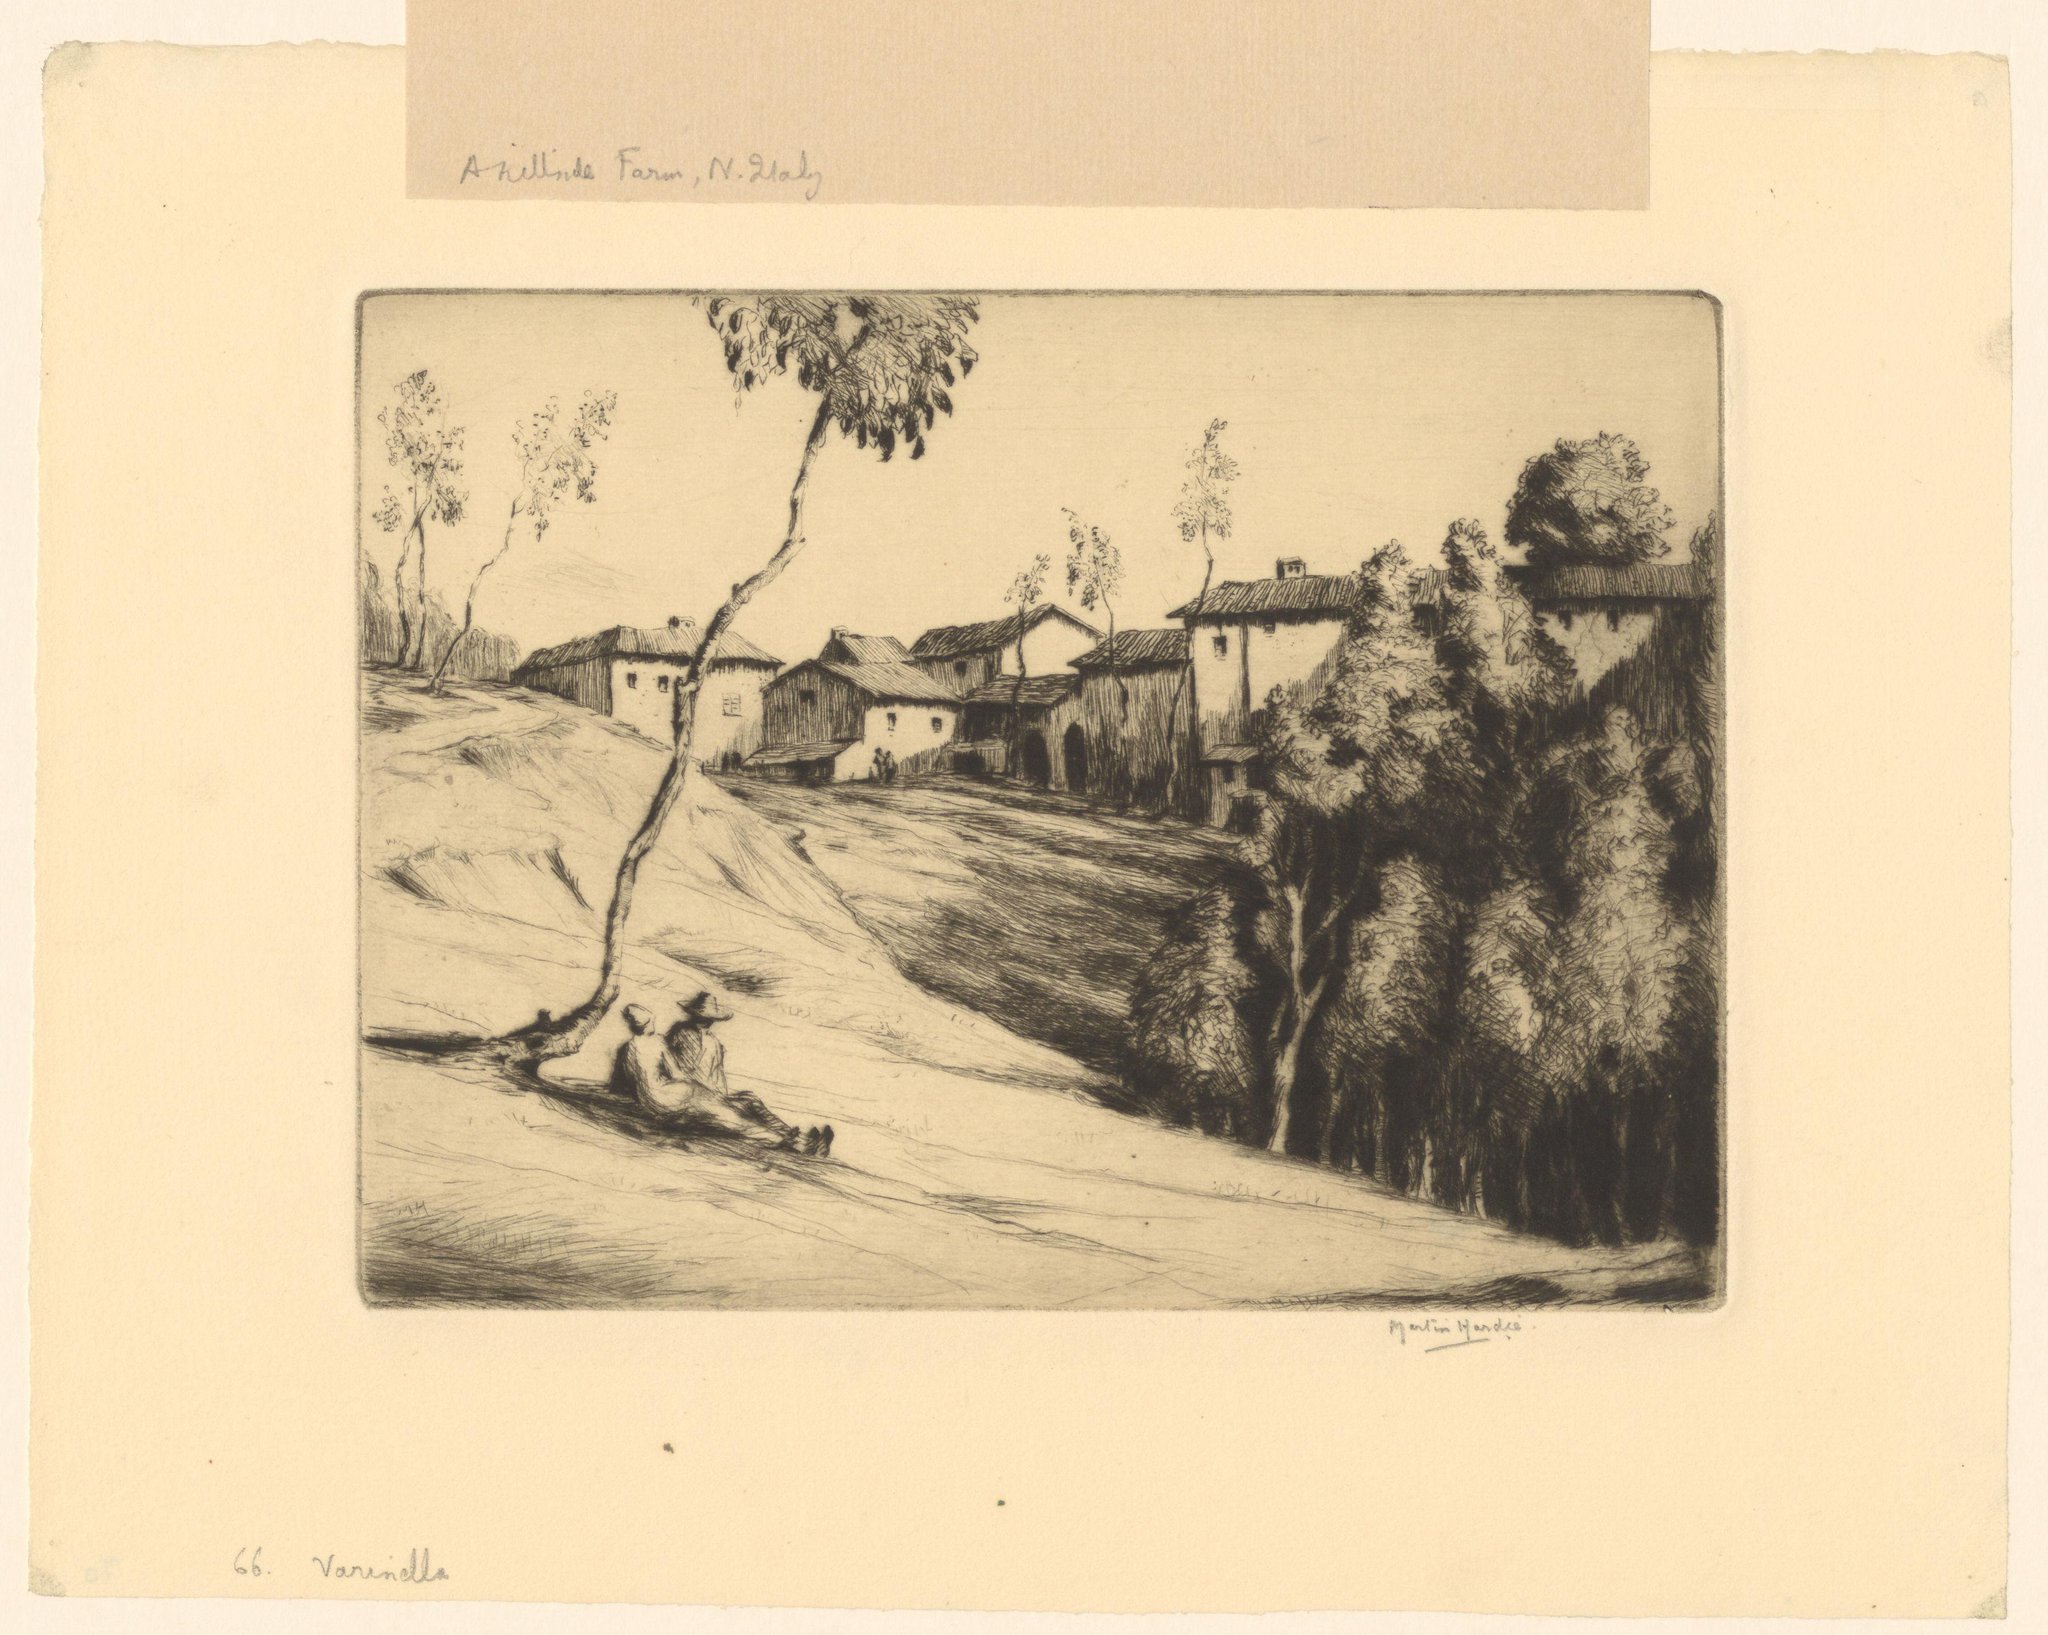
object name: print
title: Gezicht op het dorp Varinella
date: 1918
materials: paper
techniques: drypoint, etching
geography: arquata scrivia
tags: village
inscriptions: collector's mark: Lugt 2760, collector's mark: Lugt 2228, annotation: ‘Martin Hardie’